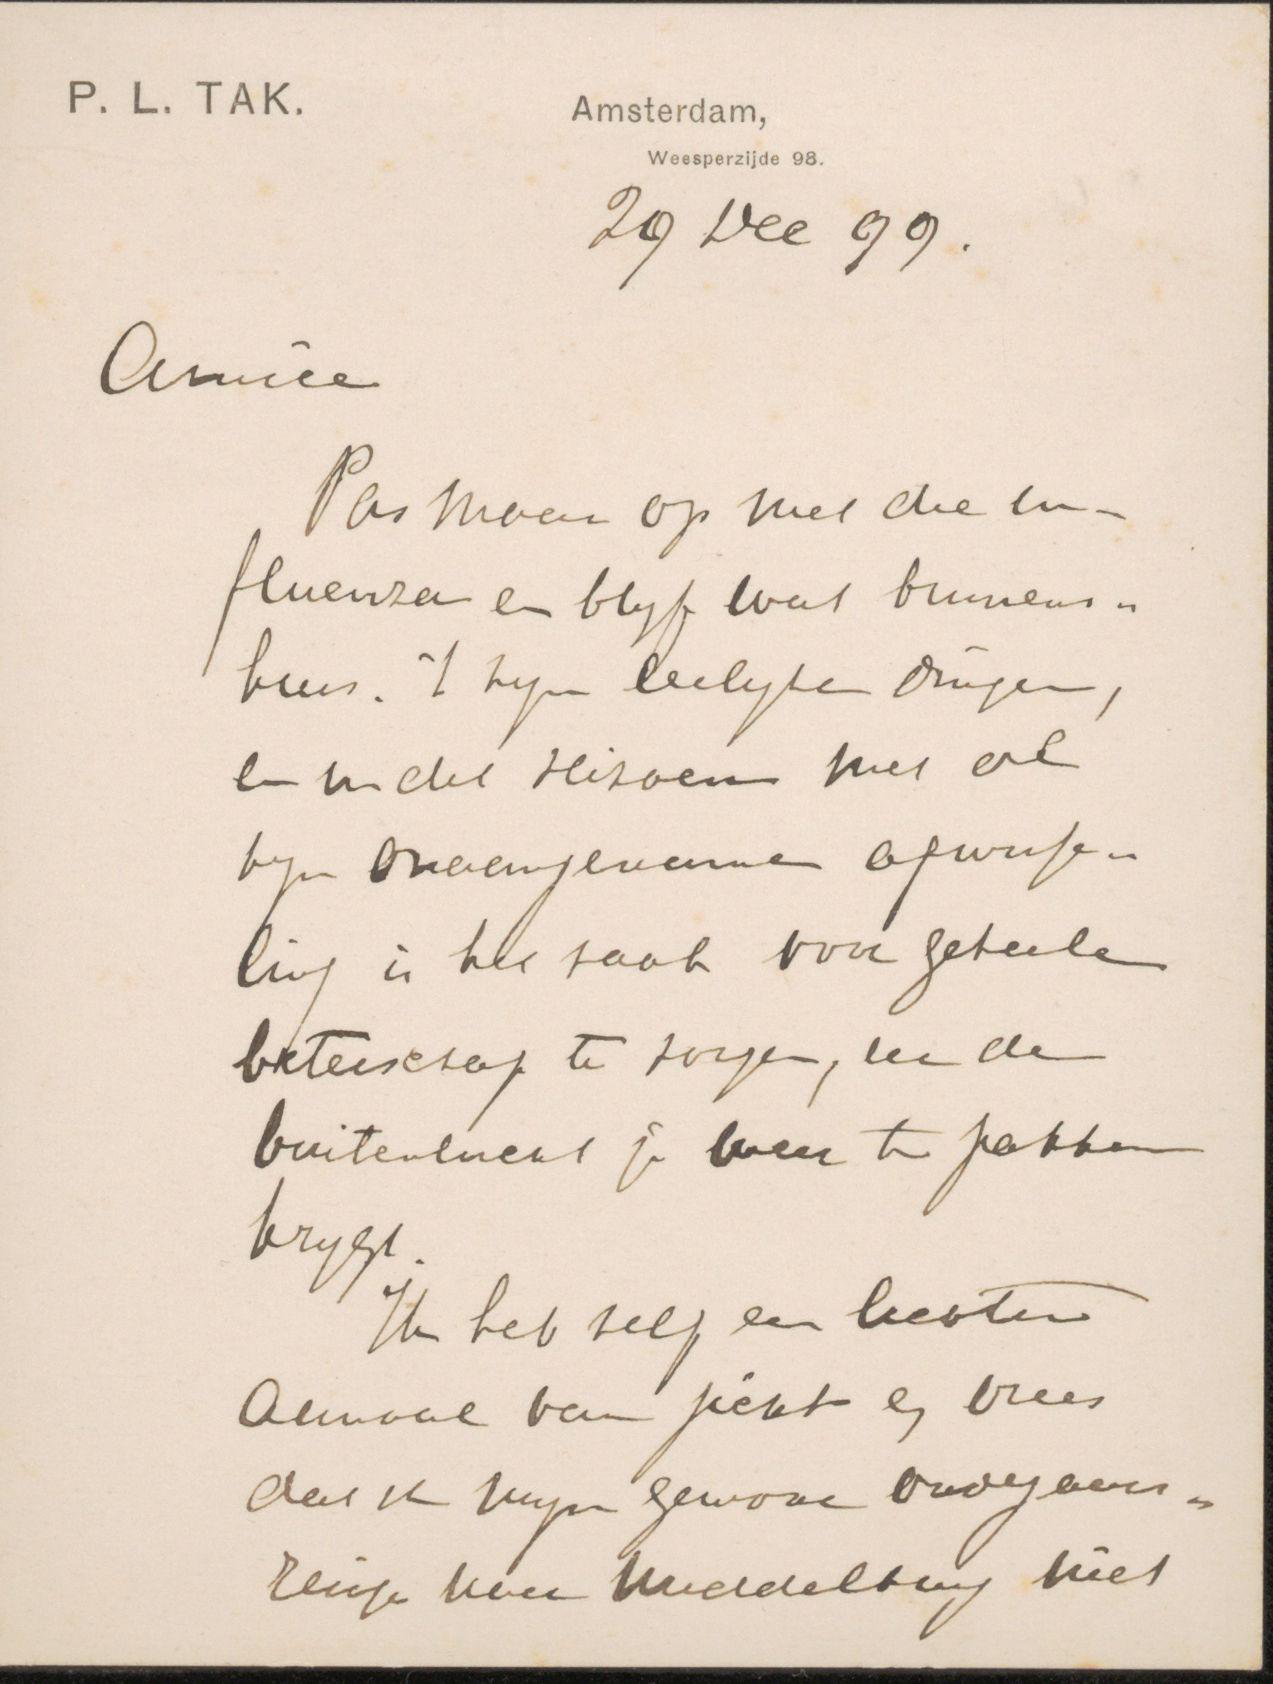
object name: letter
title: Brief aan Jan Veth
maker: pieter lodewijk tak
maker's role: politician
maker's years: 1848-1907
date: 1899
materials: cardboard, ink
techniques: pen, printing, writing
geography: amsterdam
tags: dordrecht, painter, print maker, draughtsman, designer, jan veth, diseases, printed matter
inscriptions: collector's mark: ‘RPK’